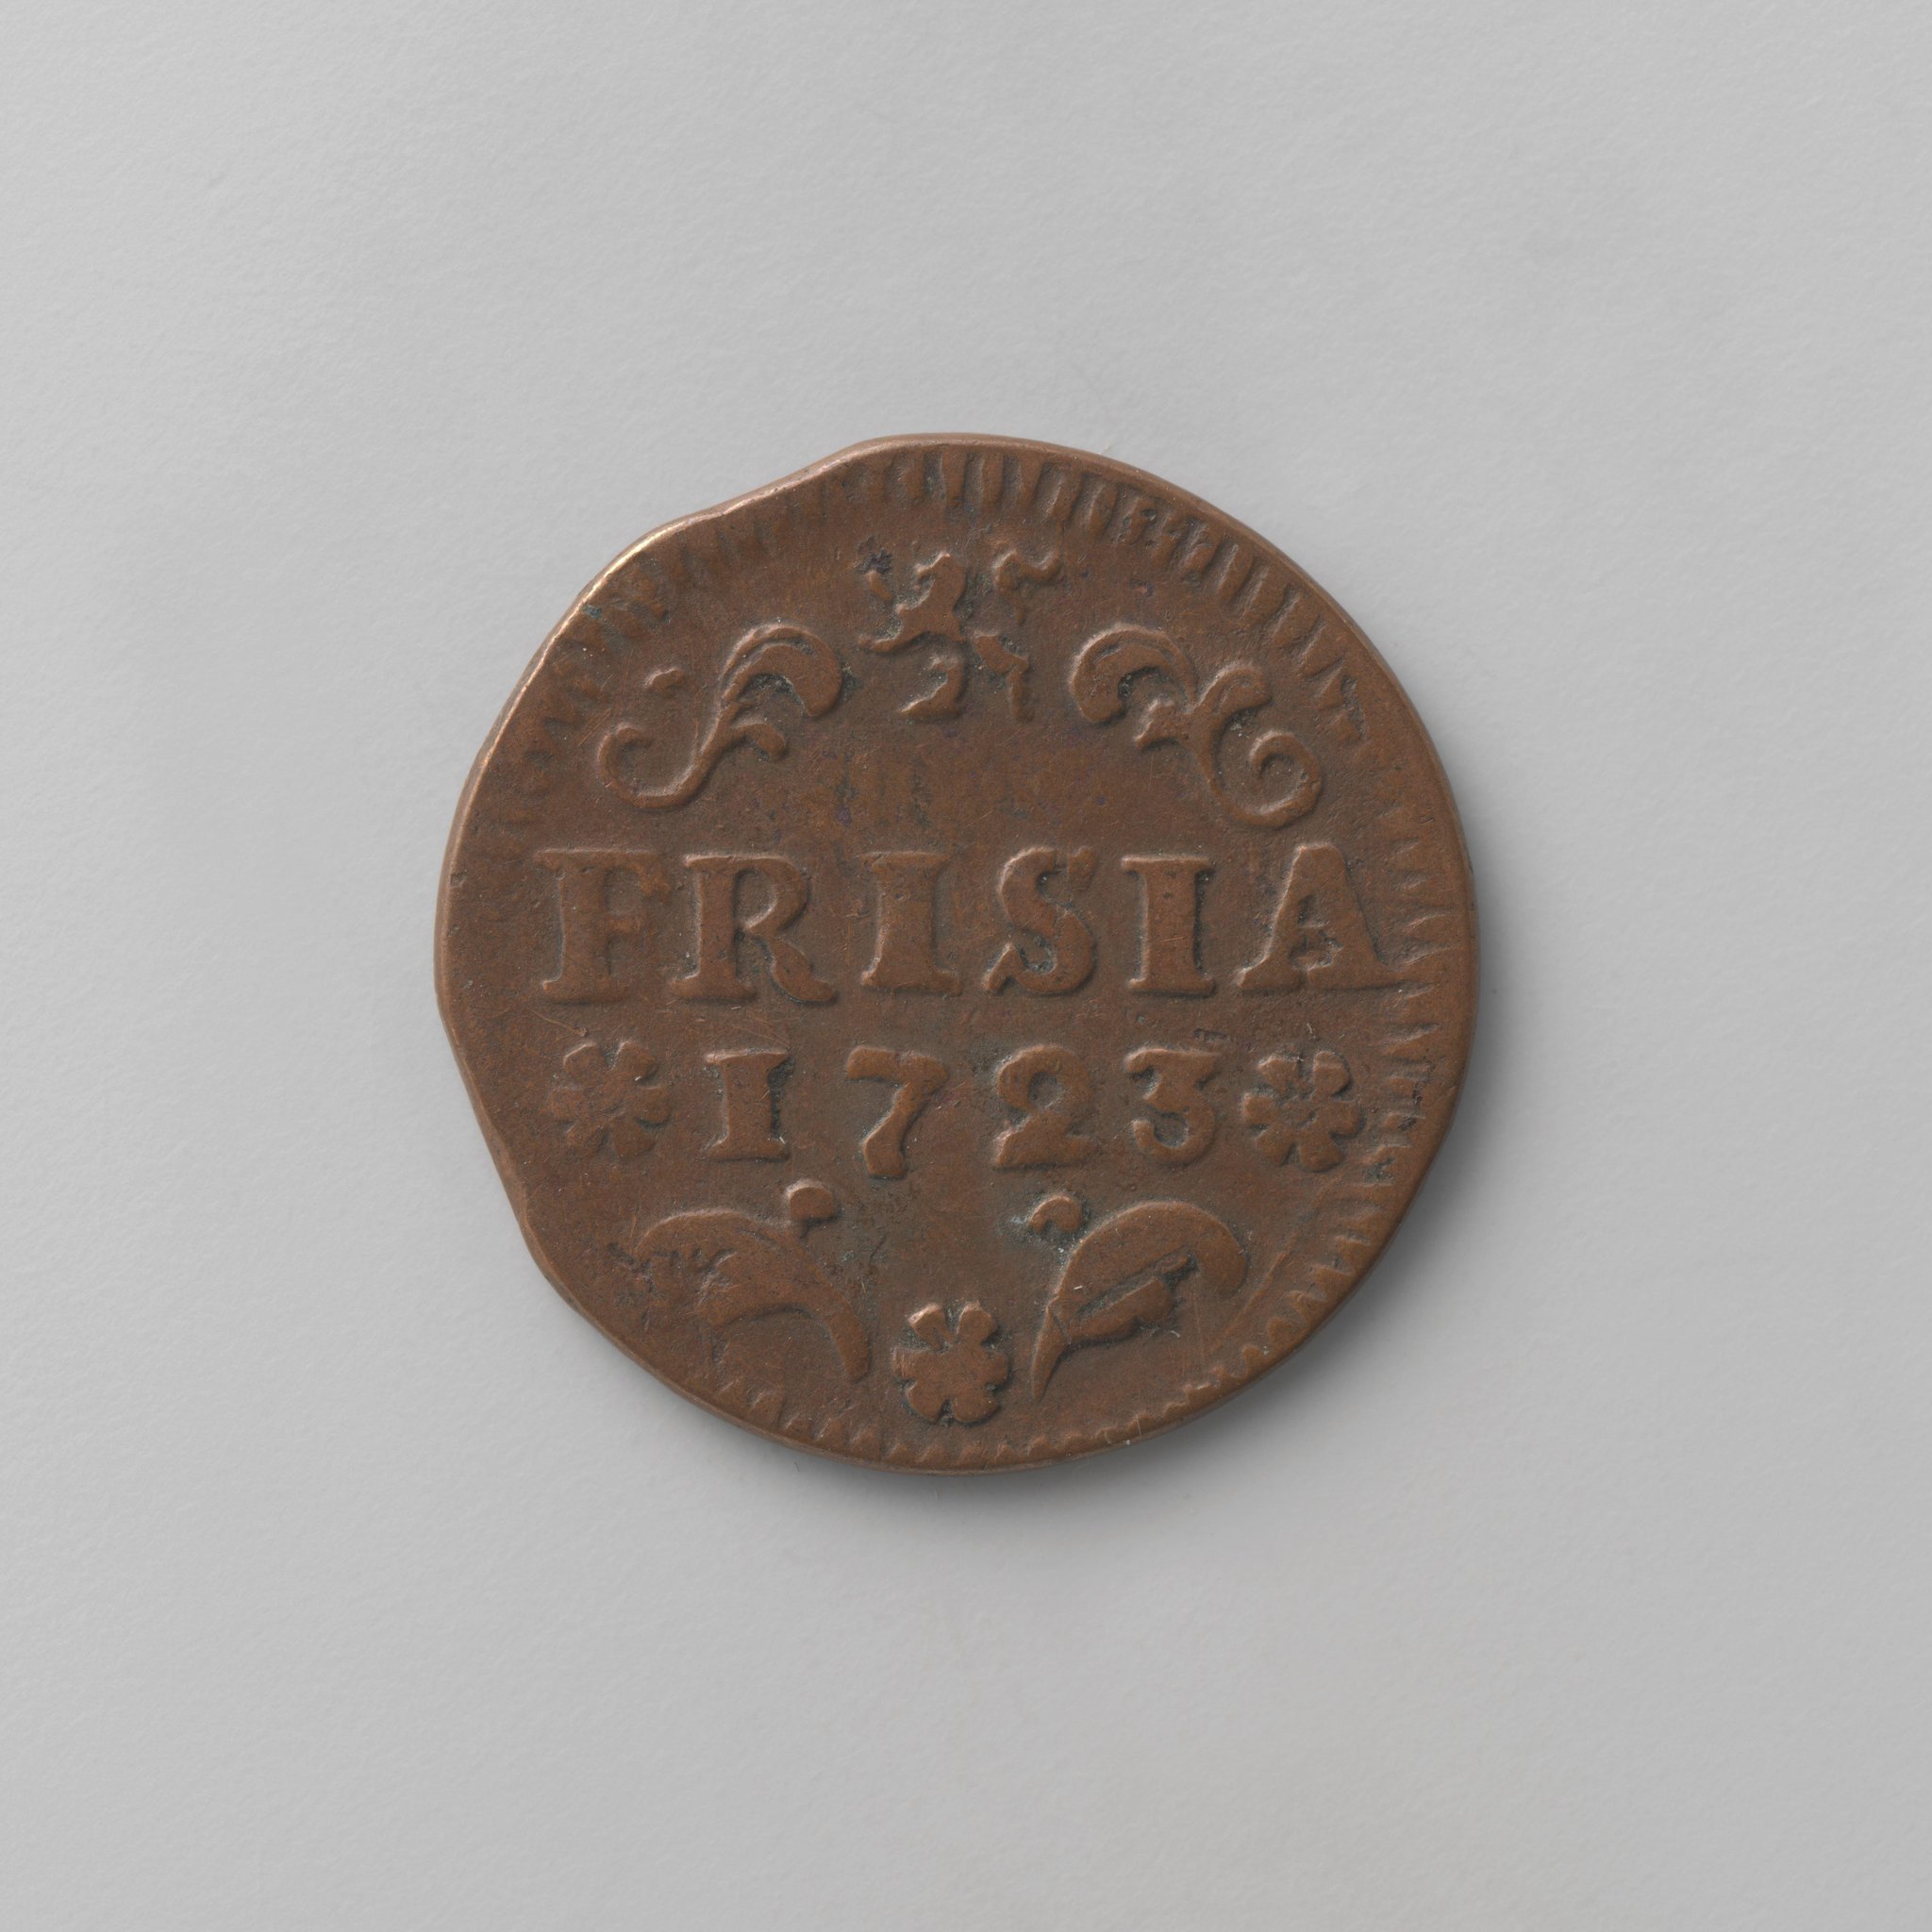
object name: coin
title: Friesland, duit, 1723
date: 1723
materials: copper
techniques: striking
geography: leeuwarden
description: Koperen munt. Voorzijde: gekroond wapenschild van Friesland met naar boven uitwijkende bladversiering. Keerzijde: muntteken tussen guirlandes, daaronder opschrift in een regel, waaronder jaartal. Daaronder rozet tussen twee guirlandes.